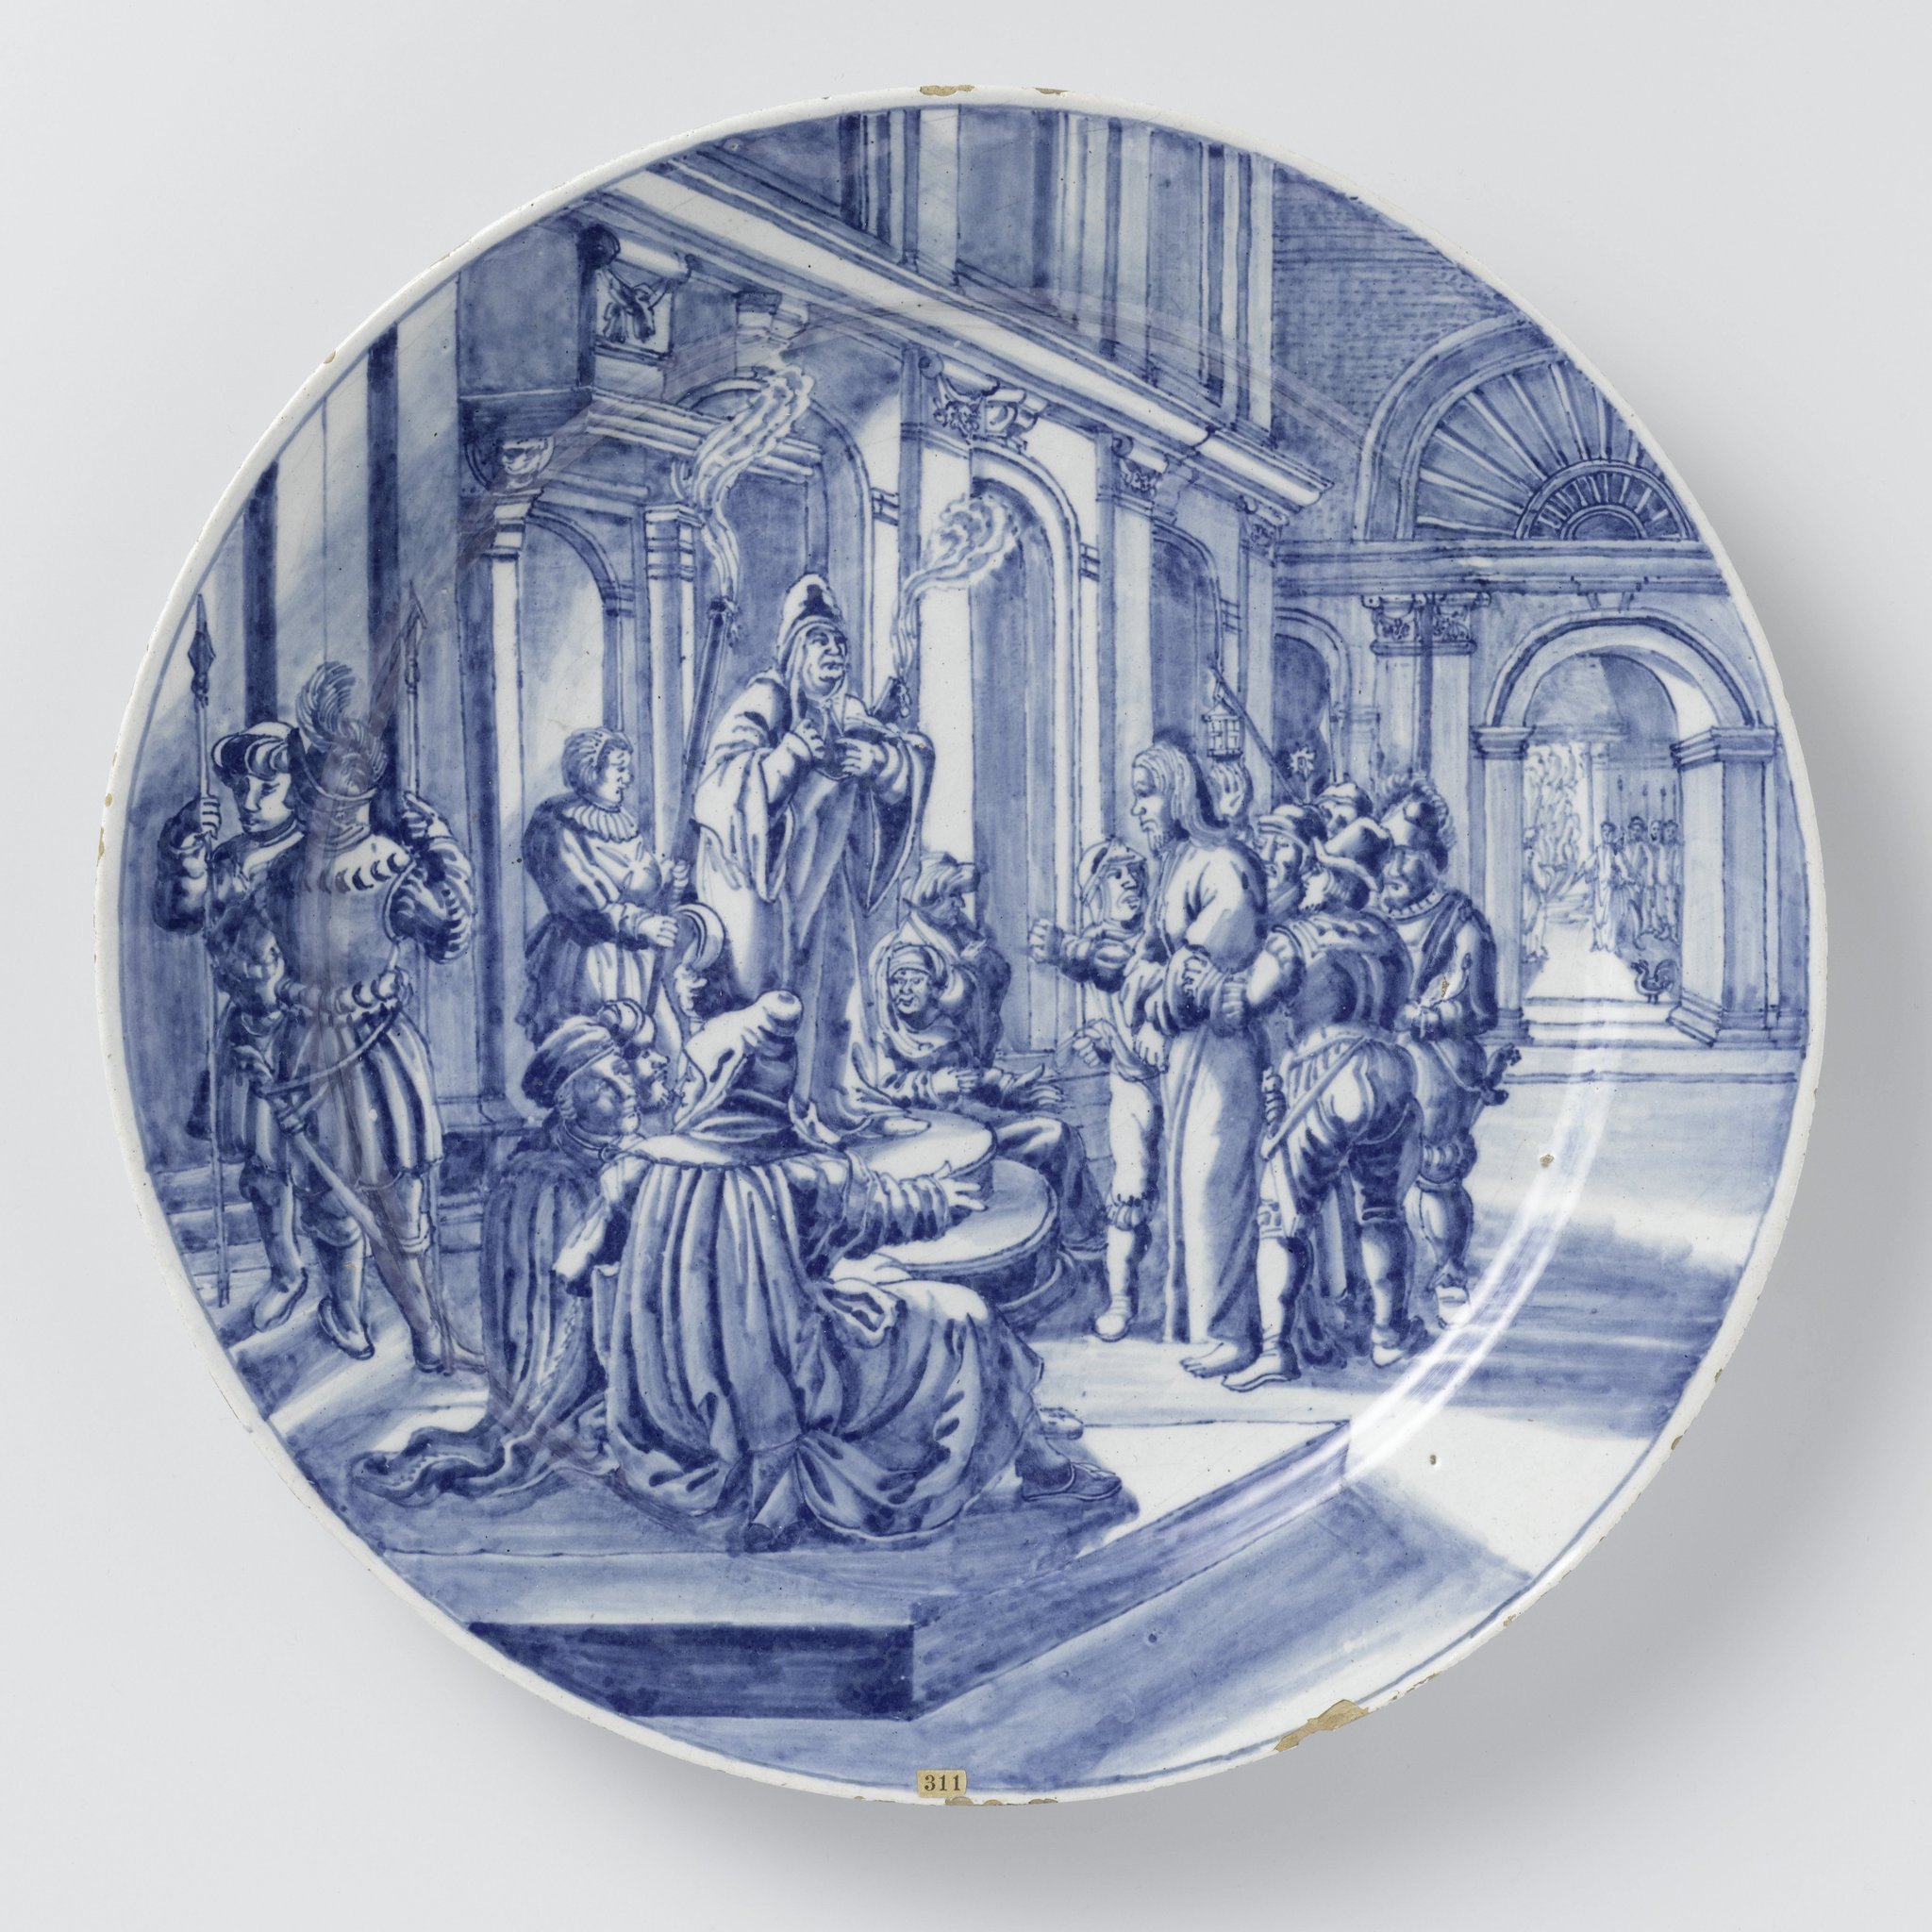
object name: plate dish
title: Plate with Christ before Caiaphas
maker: dammas hofdijck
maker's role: eigenaar plateelbakkerij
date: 1700-1725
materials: earthenware, glaze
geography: delft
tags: christ before the sanhedrin with caiaphas as high priest, and possibly annas; maybe a soldier about to strike christ because he keeps silent (matthew 26:57-66; mark 14:53-64; luke 22:54, 22:66-71), peter denies christ, usually before a girl-servant and some soldiers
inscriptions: inscription: ‘311’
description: Bord van faïence met voorstellingen uit het leven van Christus naar gravures van Hendrick Goltzius.